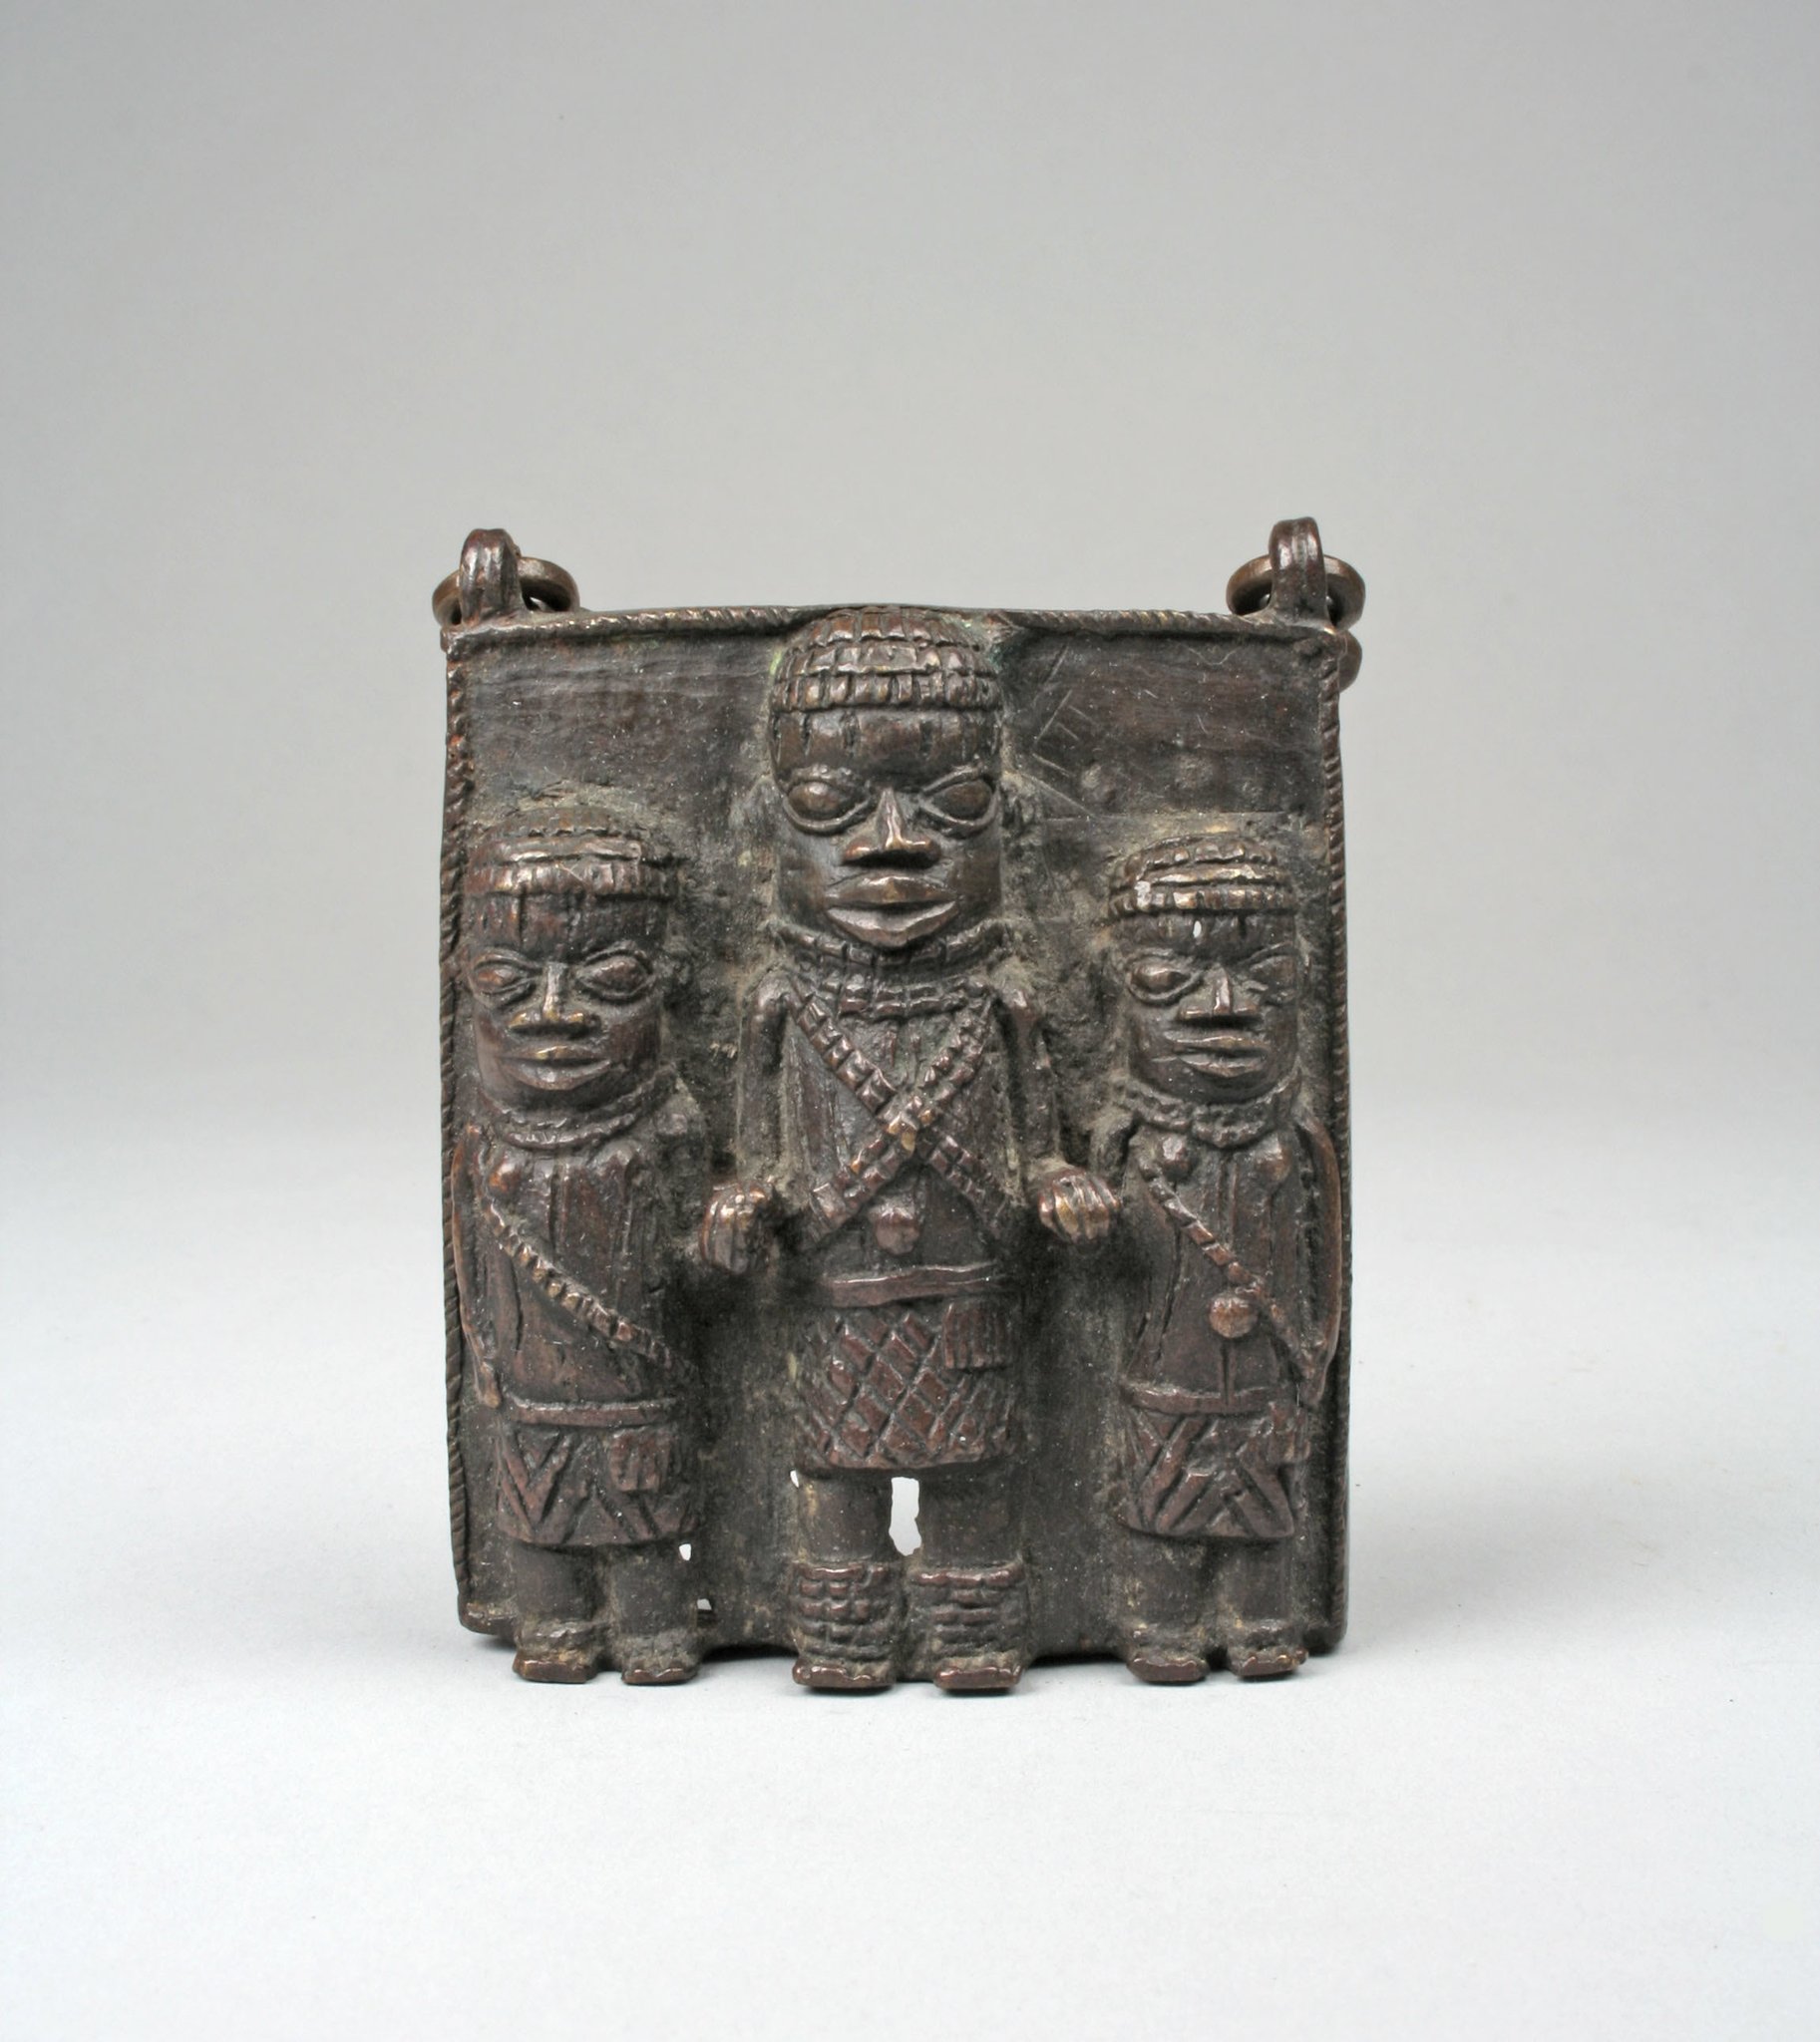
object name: pendant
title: Pendant: Three Figures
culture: edo period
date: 1801-1900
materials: brass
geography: nigeria